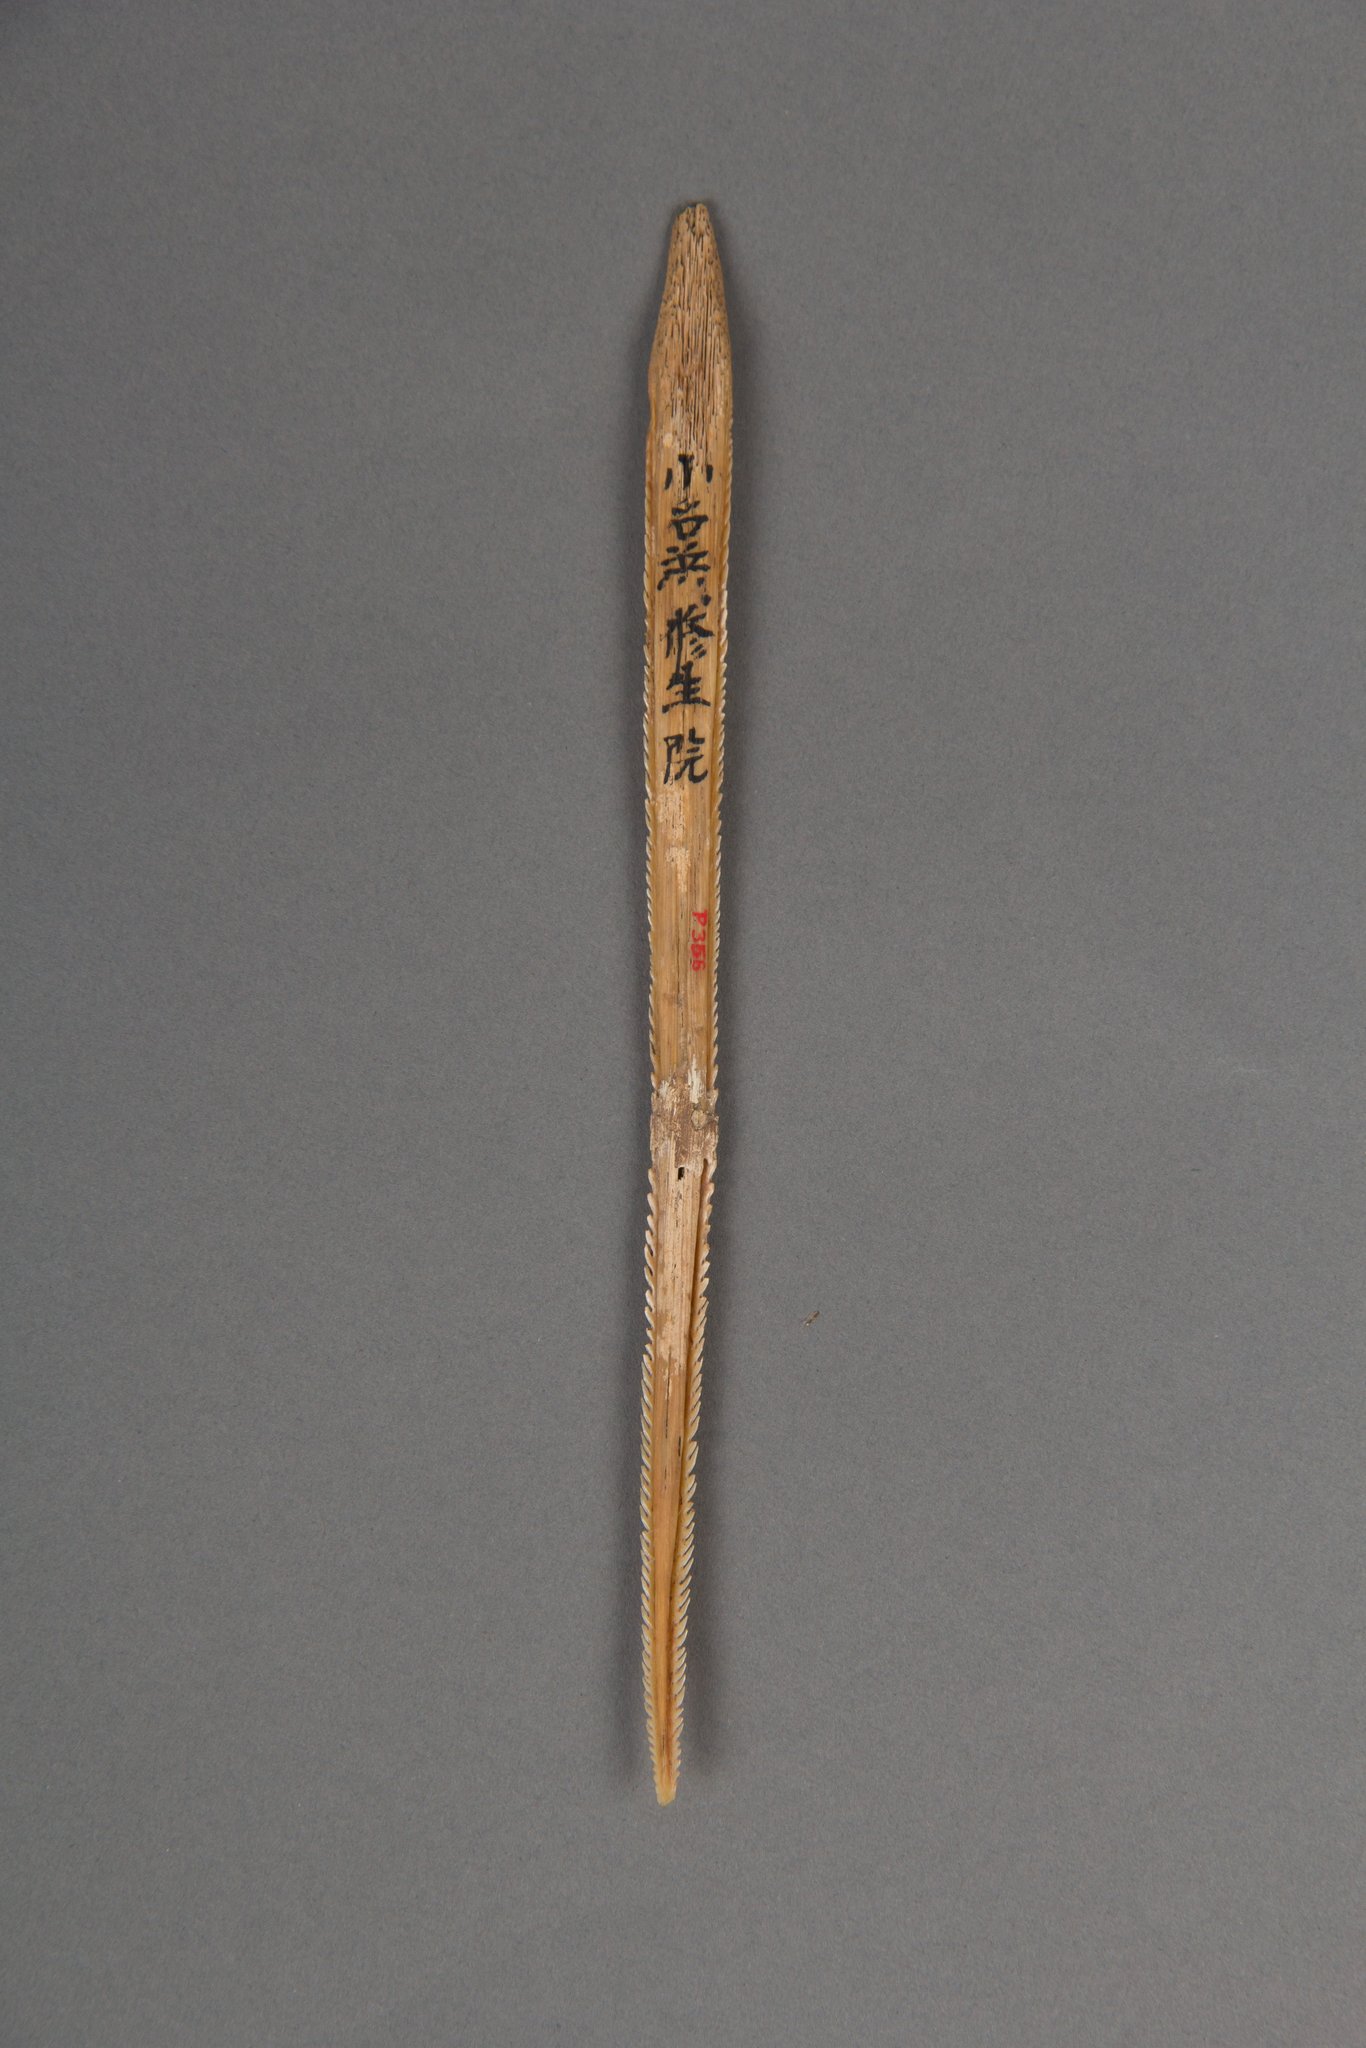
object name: harpoon head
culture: japanese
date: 1200-200 BCE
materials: bone